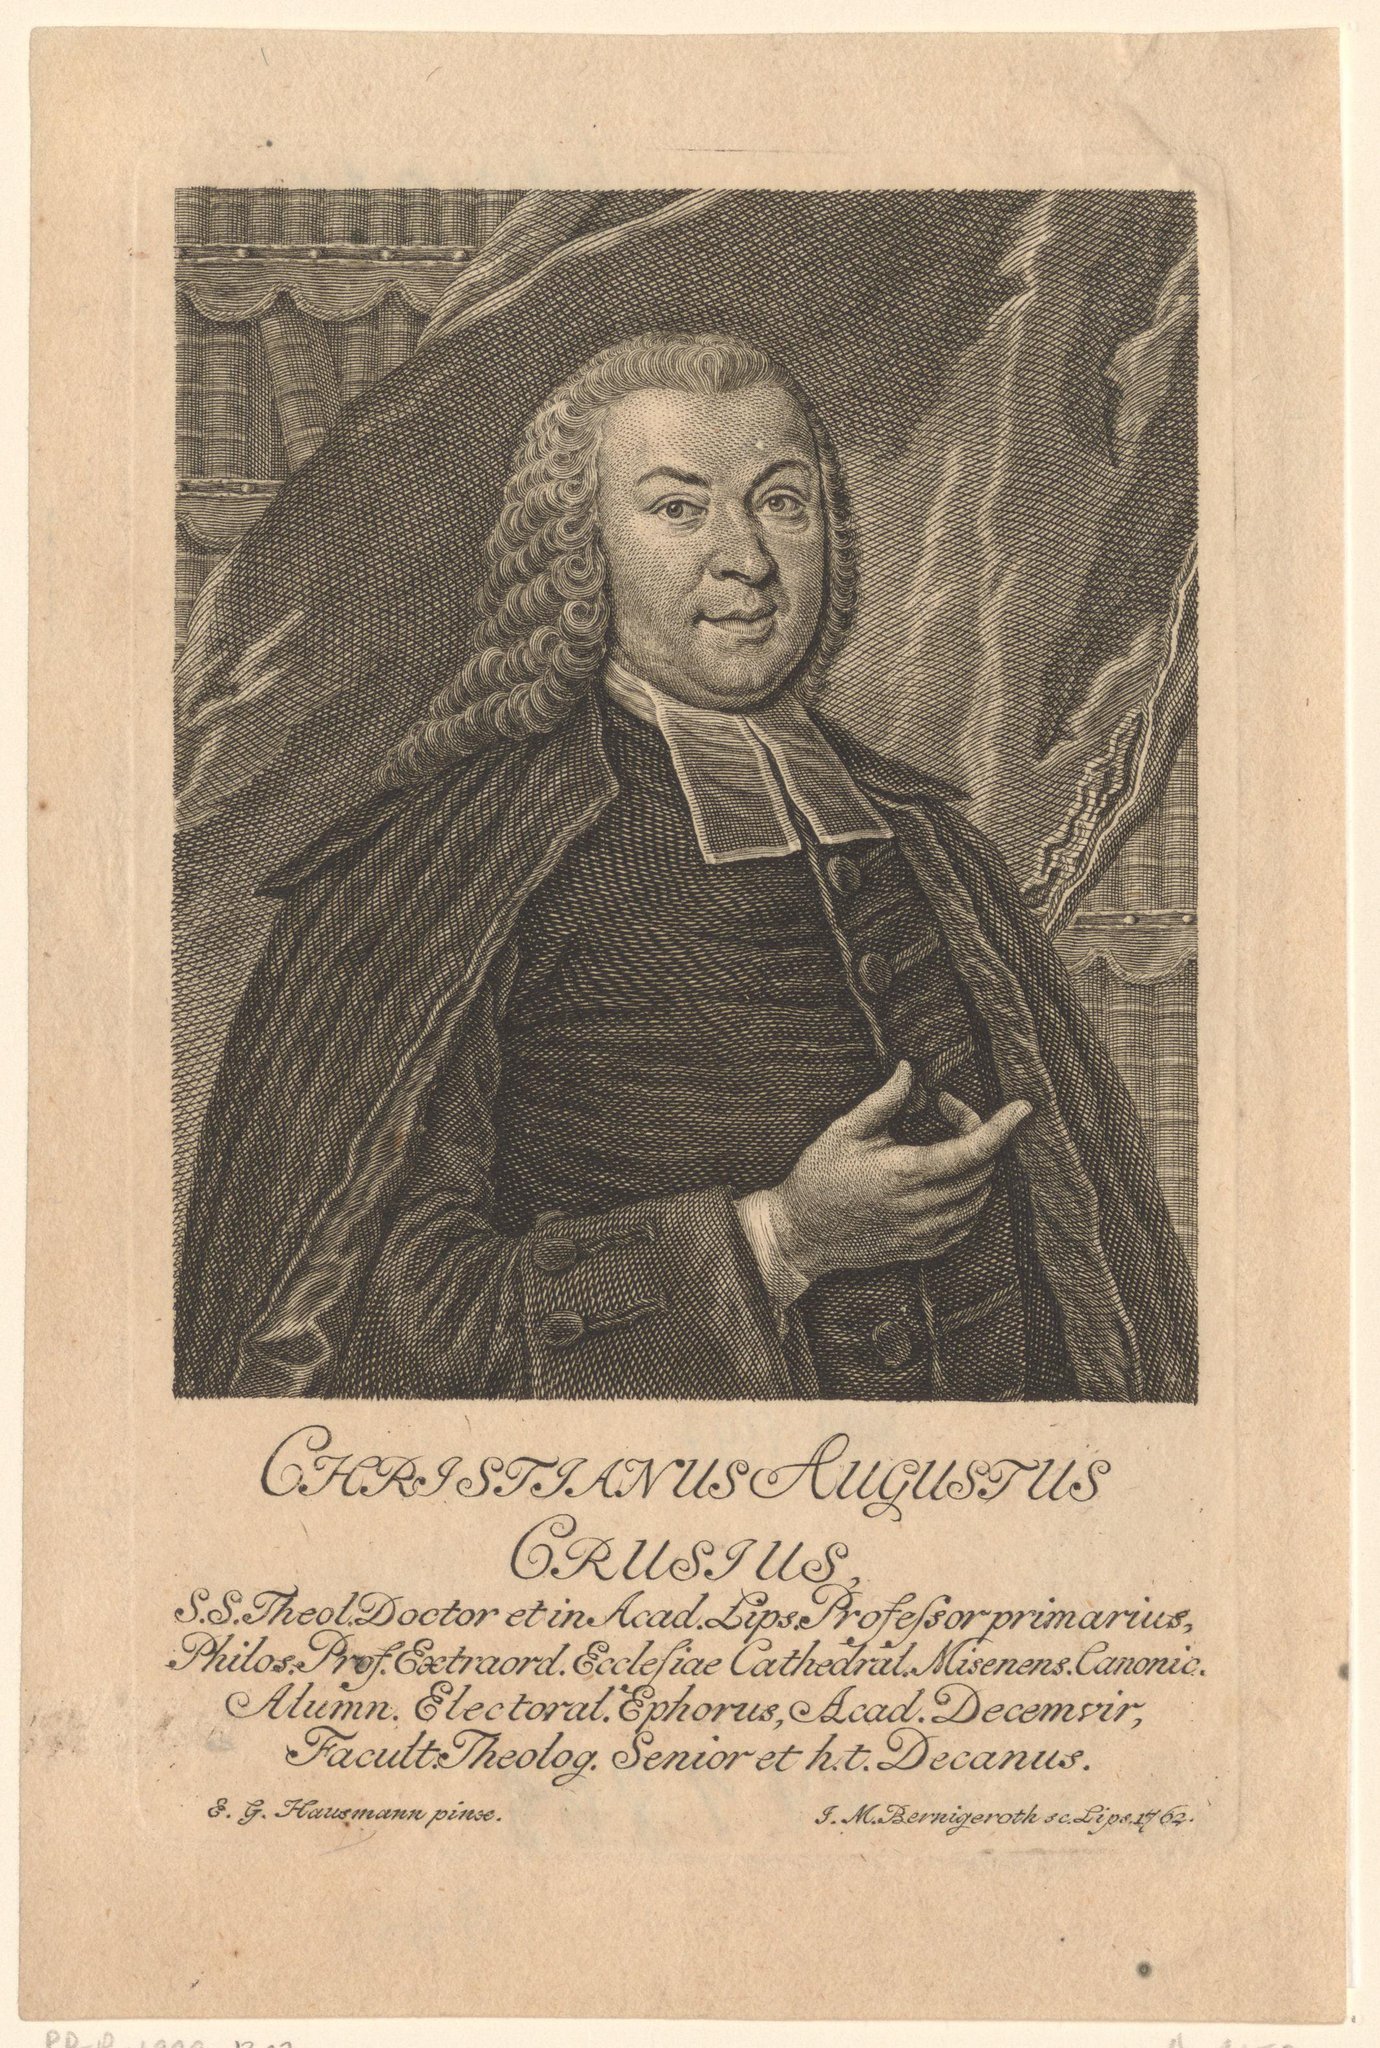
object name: print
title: Portret van Christian August Crusius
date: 1762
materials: paper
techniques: engraving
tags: historical persons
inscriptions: collector's mark: Lugt 2228, collector's mark: Lugt 2760